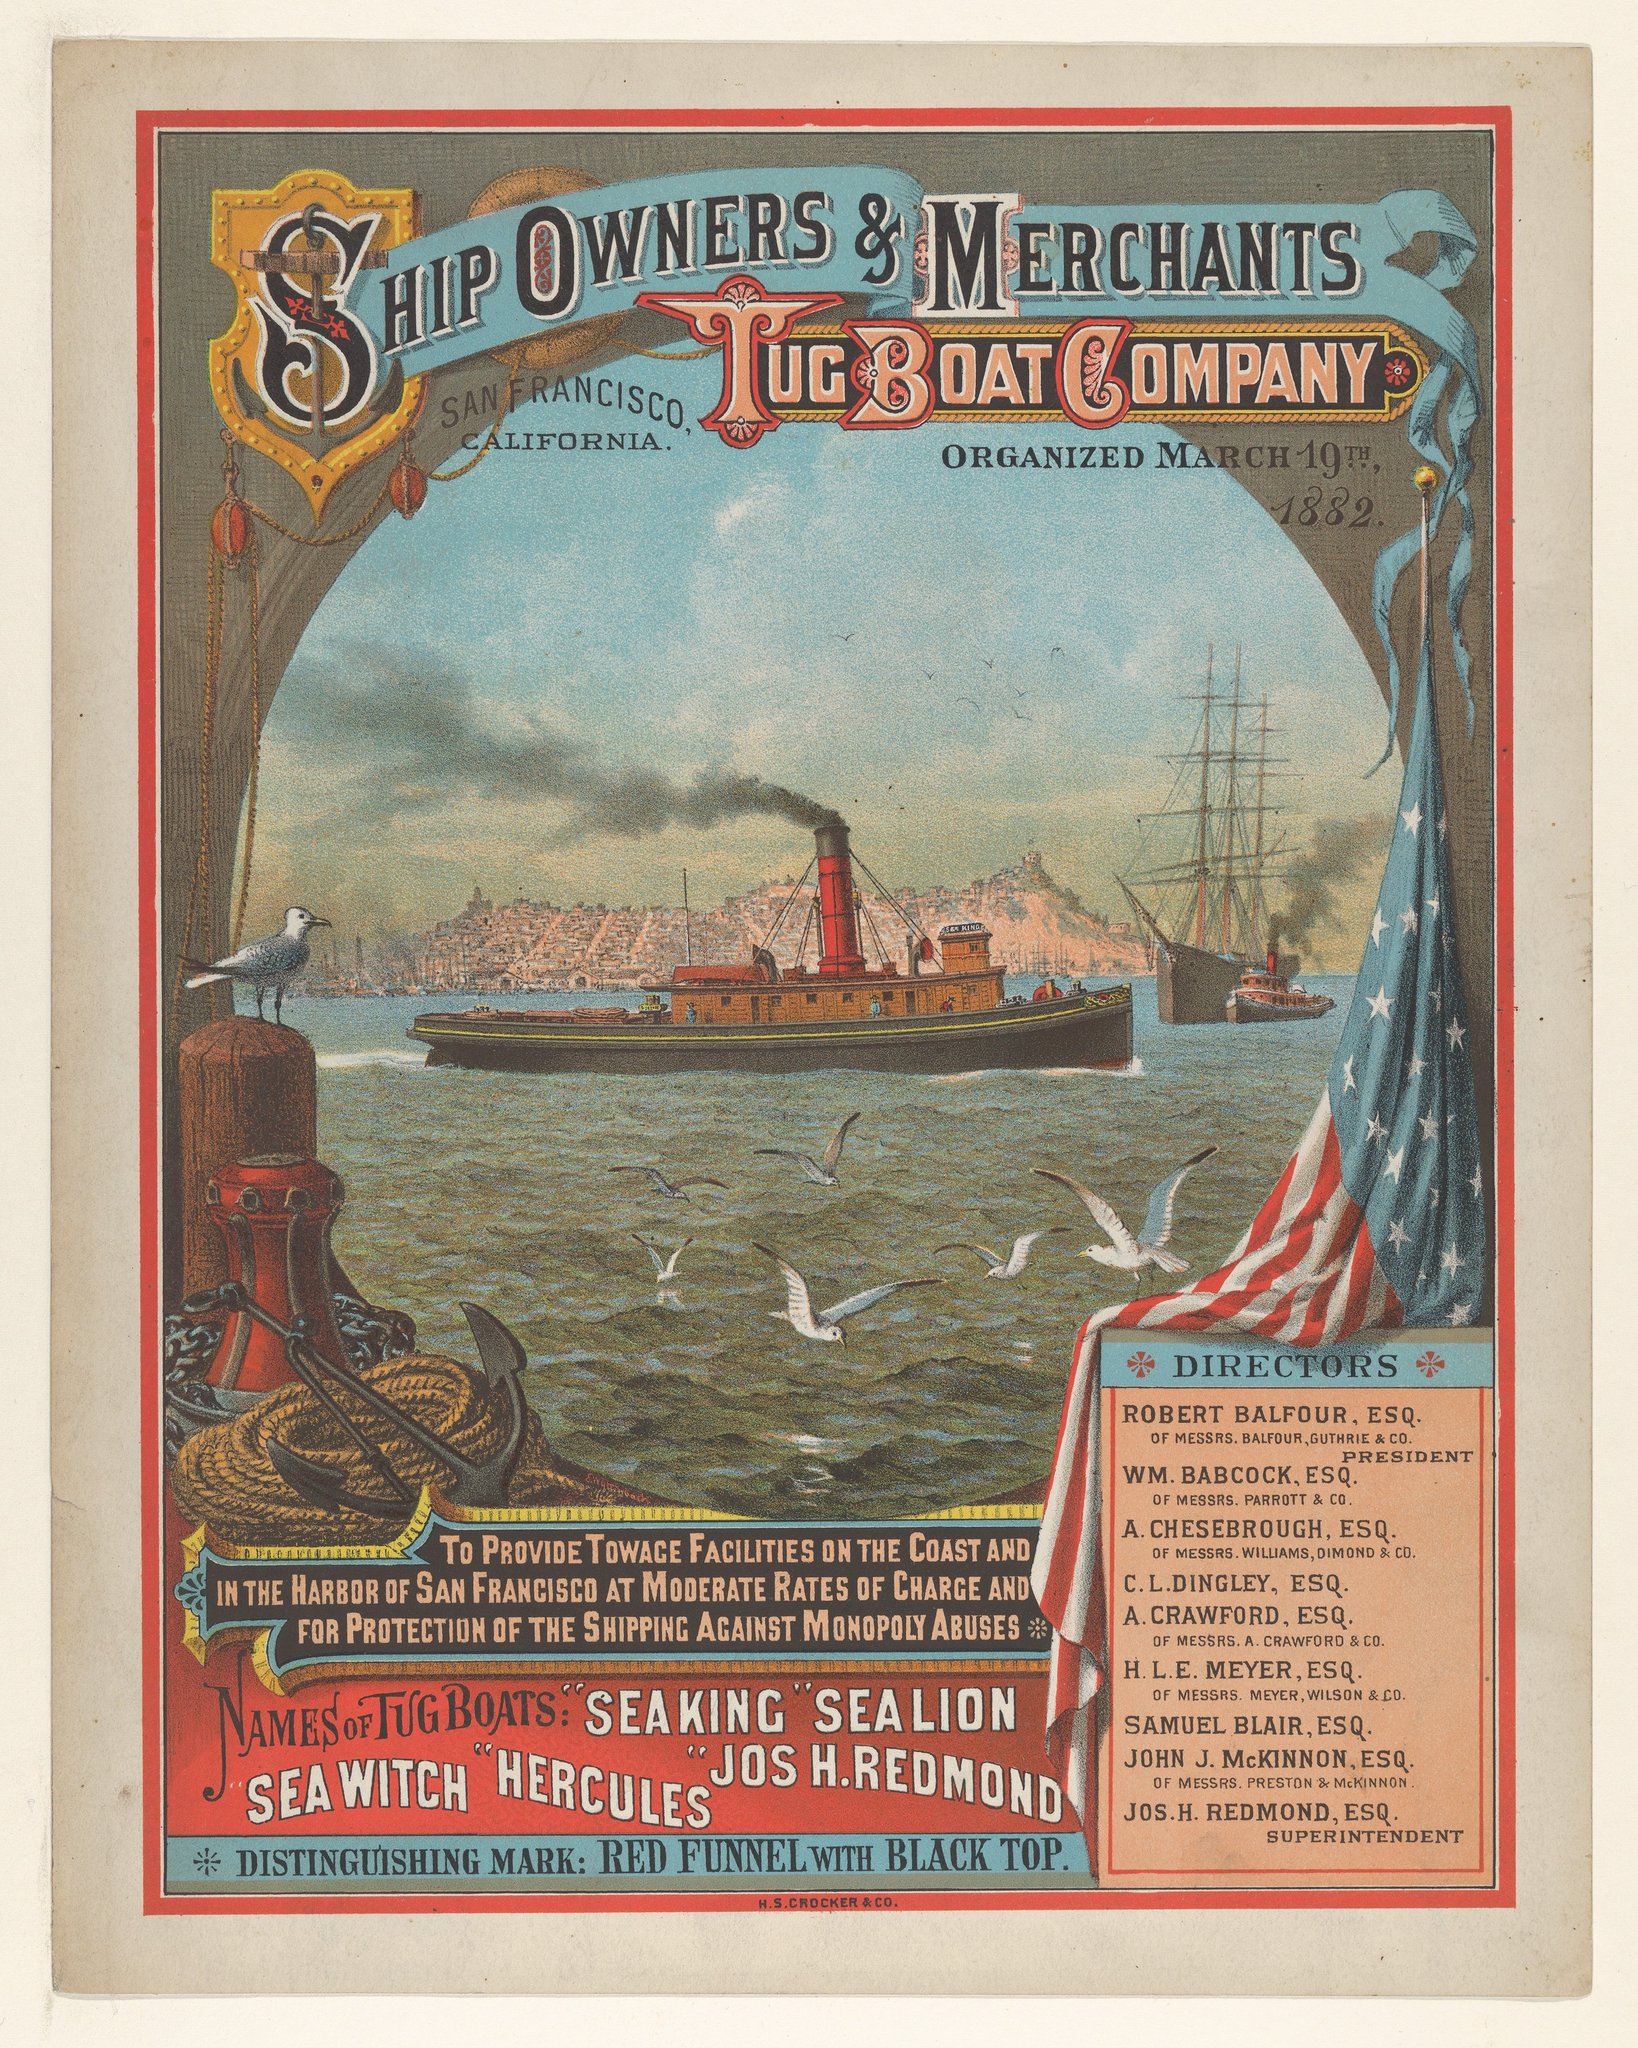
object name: print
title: Ship Owners and Merchant Tug Boat Company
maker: emmanuel wyttenbach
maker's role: artist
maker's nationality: american, born switzerland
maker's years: 1857-1903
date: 1882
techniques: lithograph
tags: ships